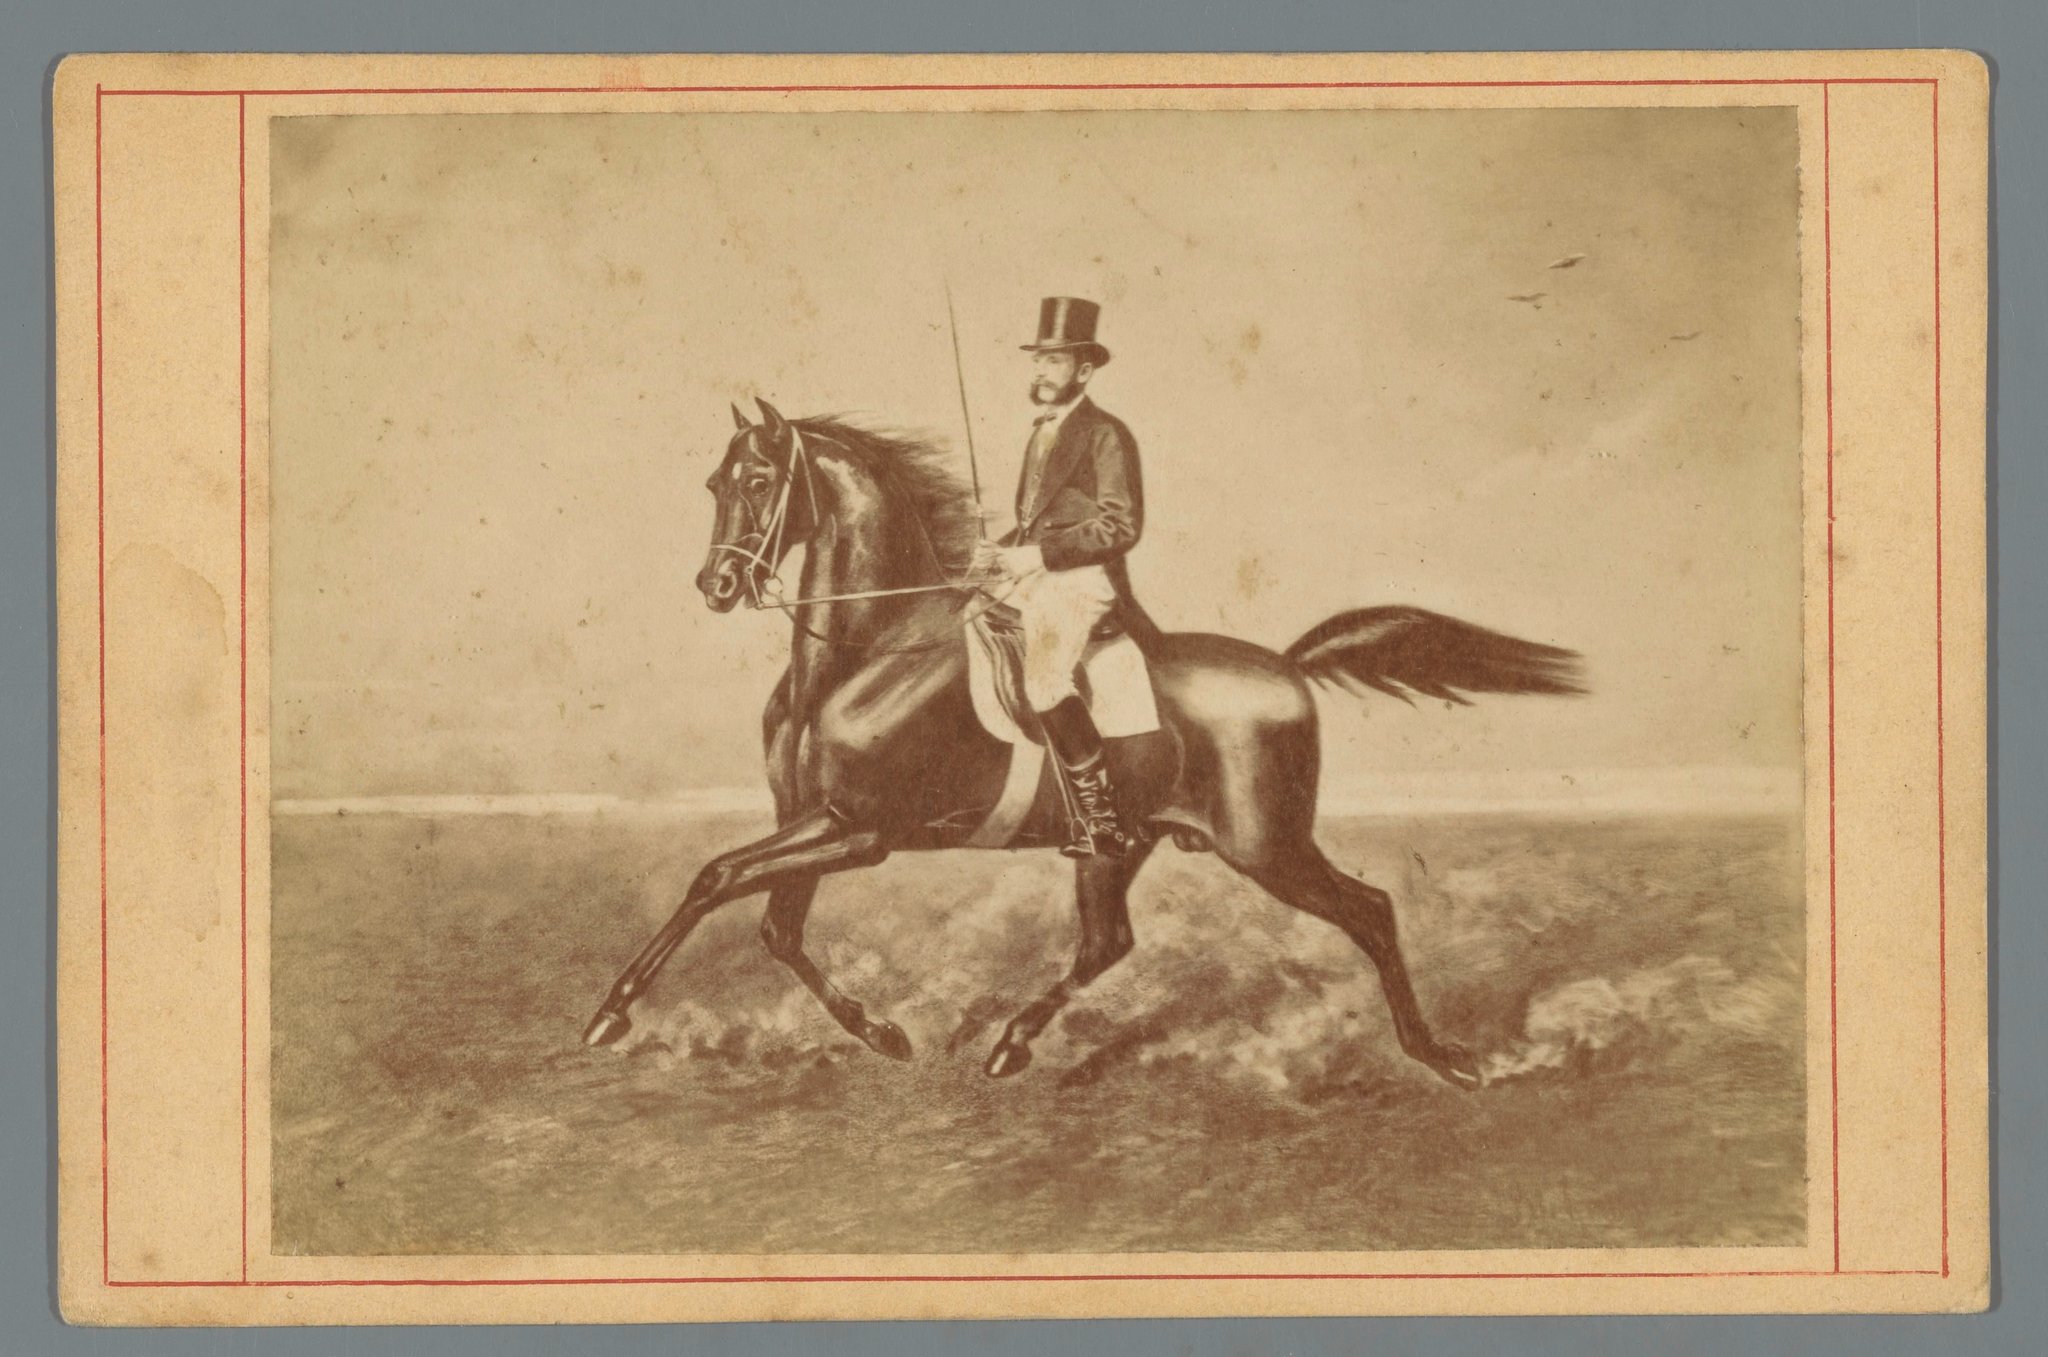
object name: cabinet photograph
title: G.L. van Lennep op 'Zampa'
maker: Anonymous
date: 1877-1890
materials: cardboard, photographic support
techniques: albumen print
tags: riding a horse, ass, or mule; rider, horseman, picture, painting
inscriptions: : ‘G.L. van Lennep / op 'Zampa' (...) toen 'Max''’